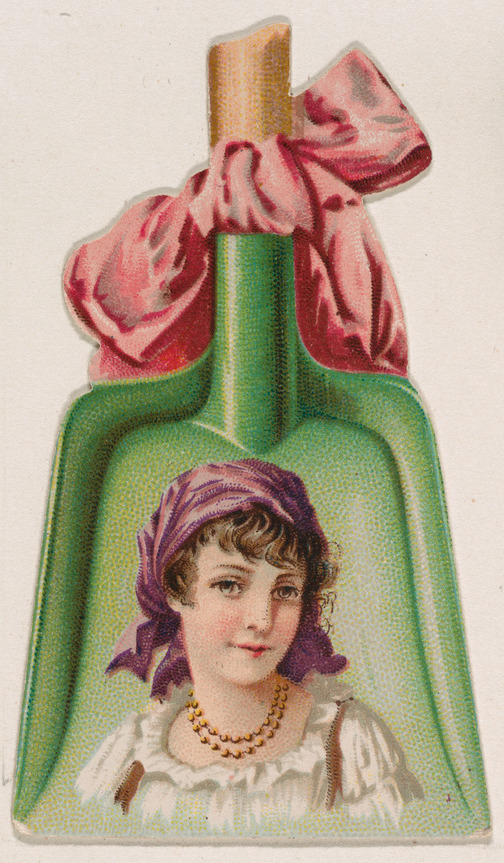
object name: print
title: Shovel, from the Novelties series (N228, Type 3) issued by Kinney Bros.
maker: kinney brothers tobacco company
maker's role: publisher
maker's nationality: american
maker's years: 1869-2011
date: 1889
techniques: color lithograph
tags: women,tools